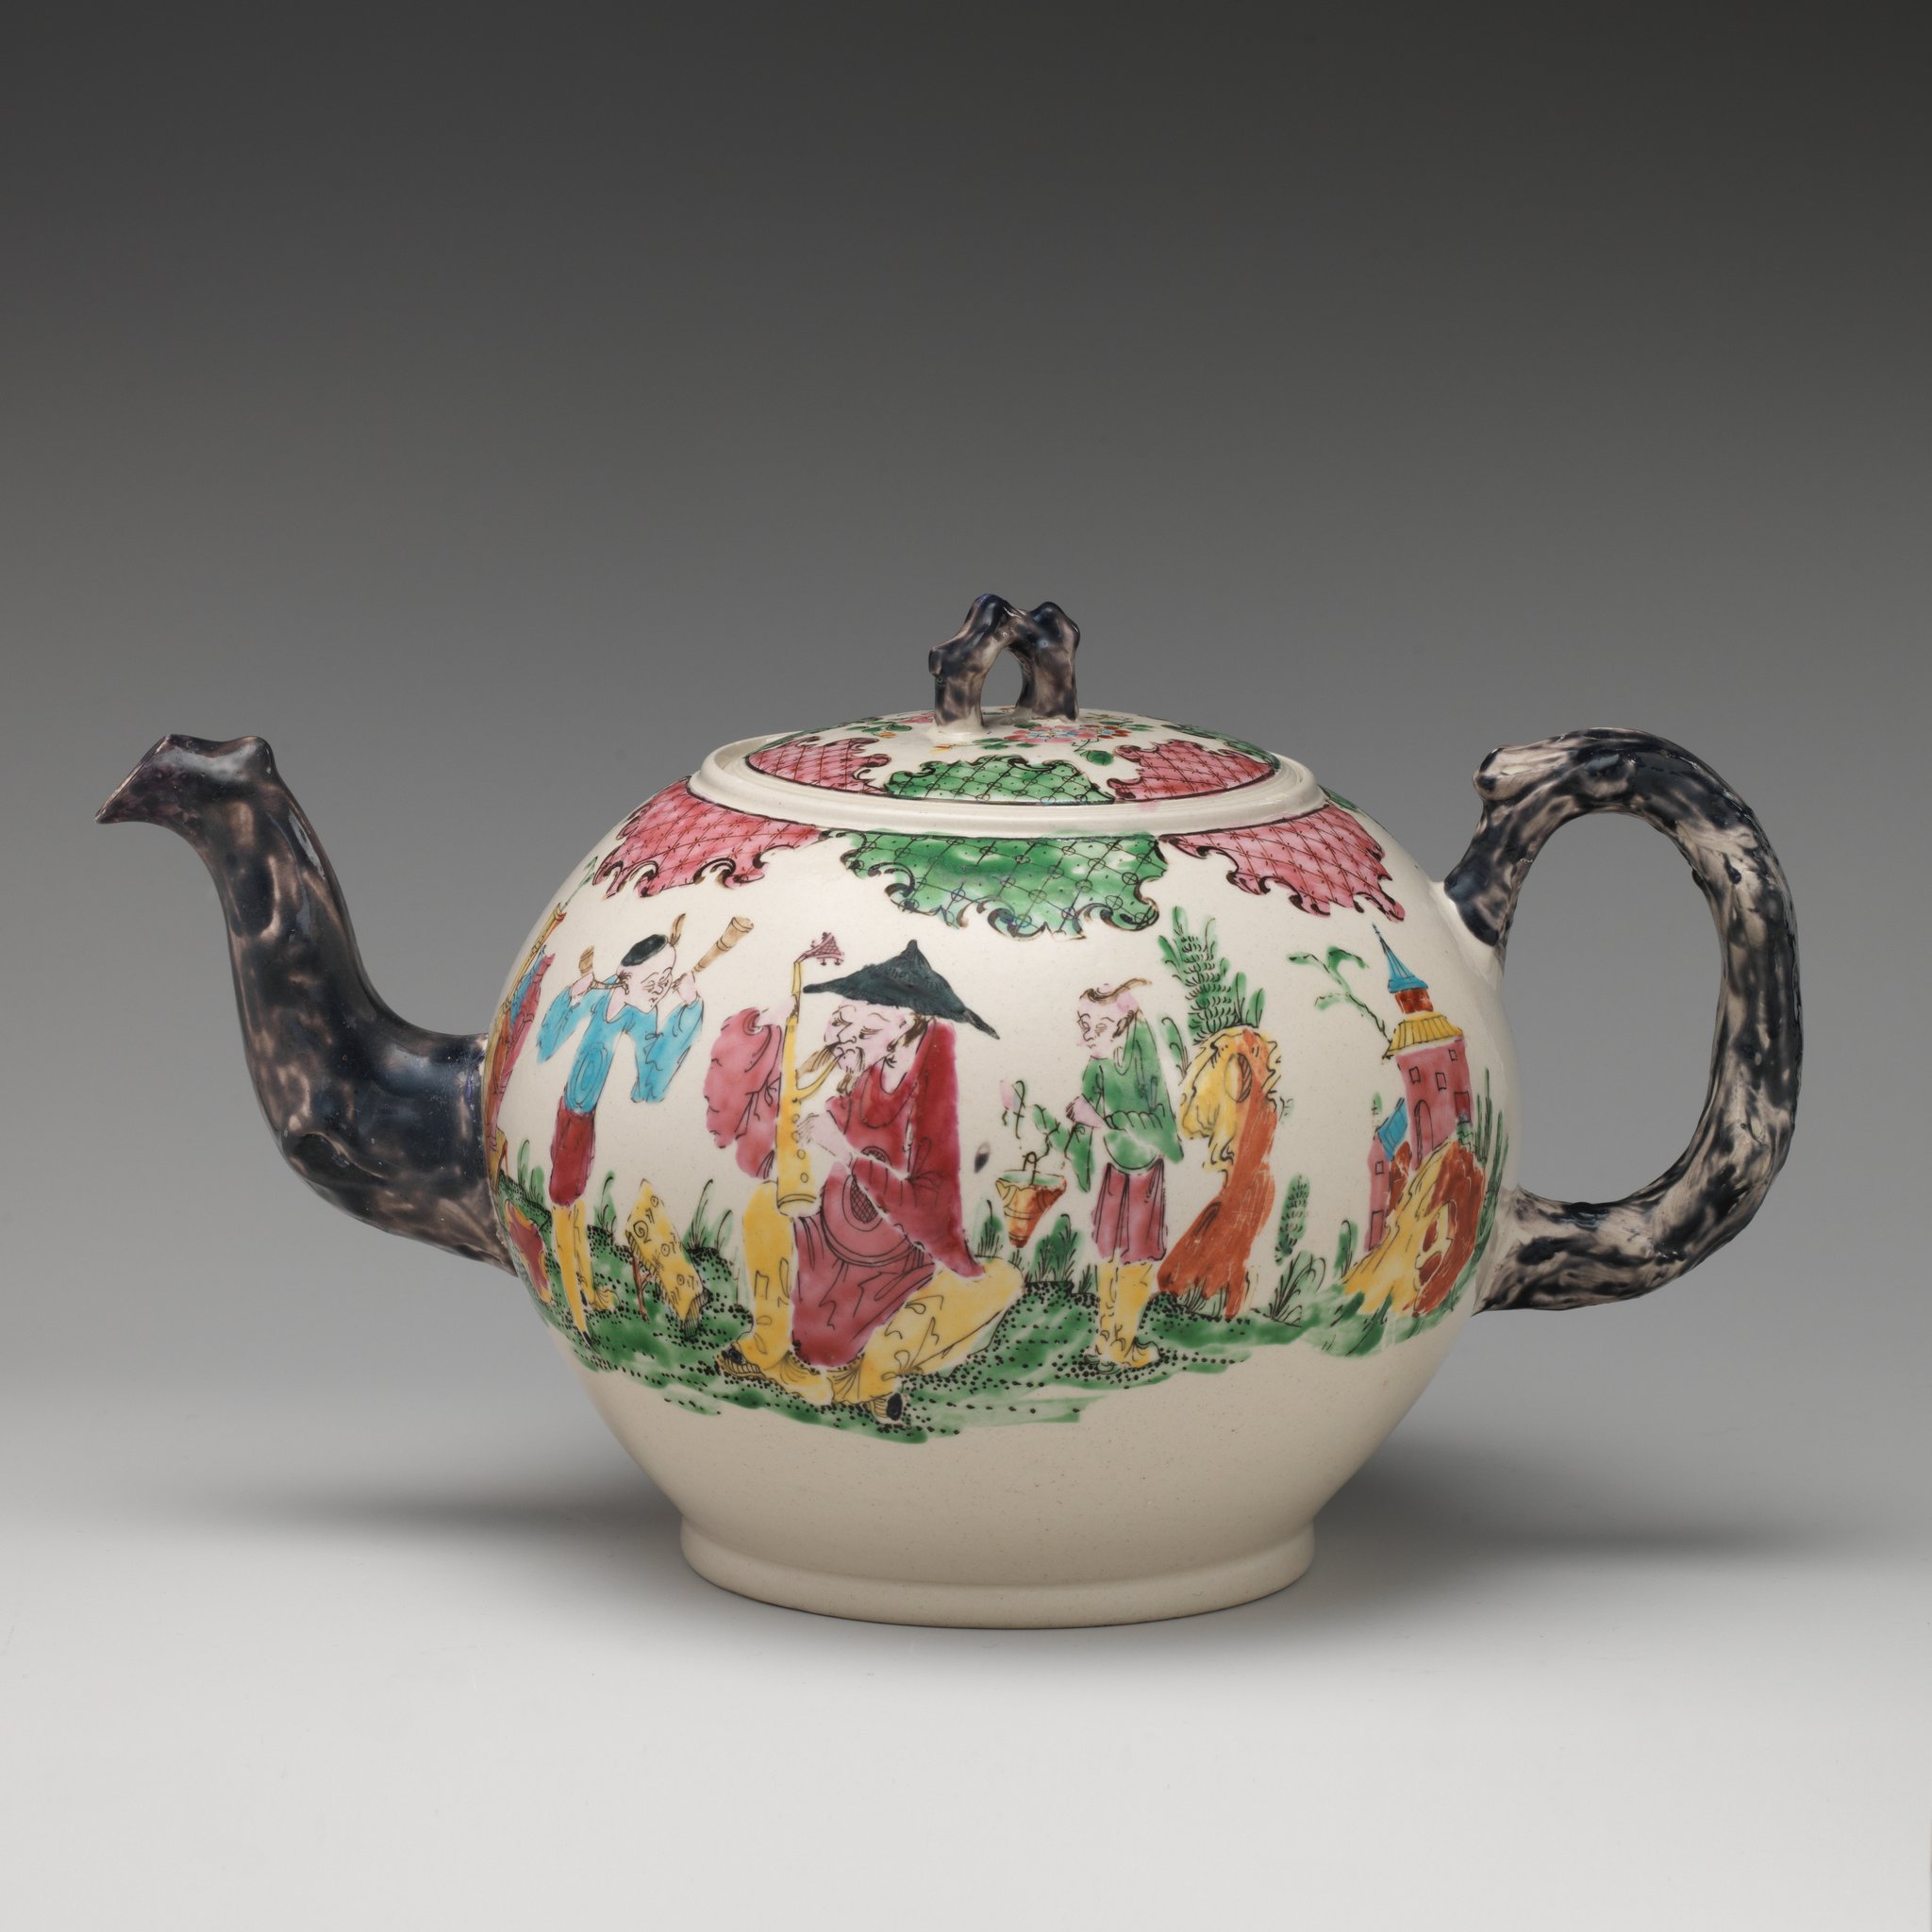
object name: punch pot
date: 1755-1760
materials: enamel, stoneware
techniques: salt glaze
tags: musical instruments,chinoiserie,men,musicians